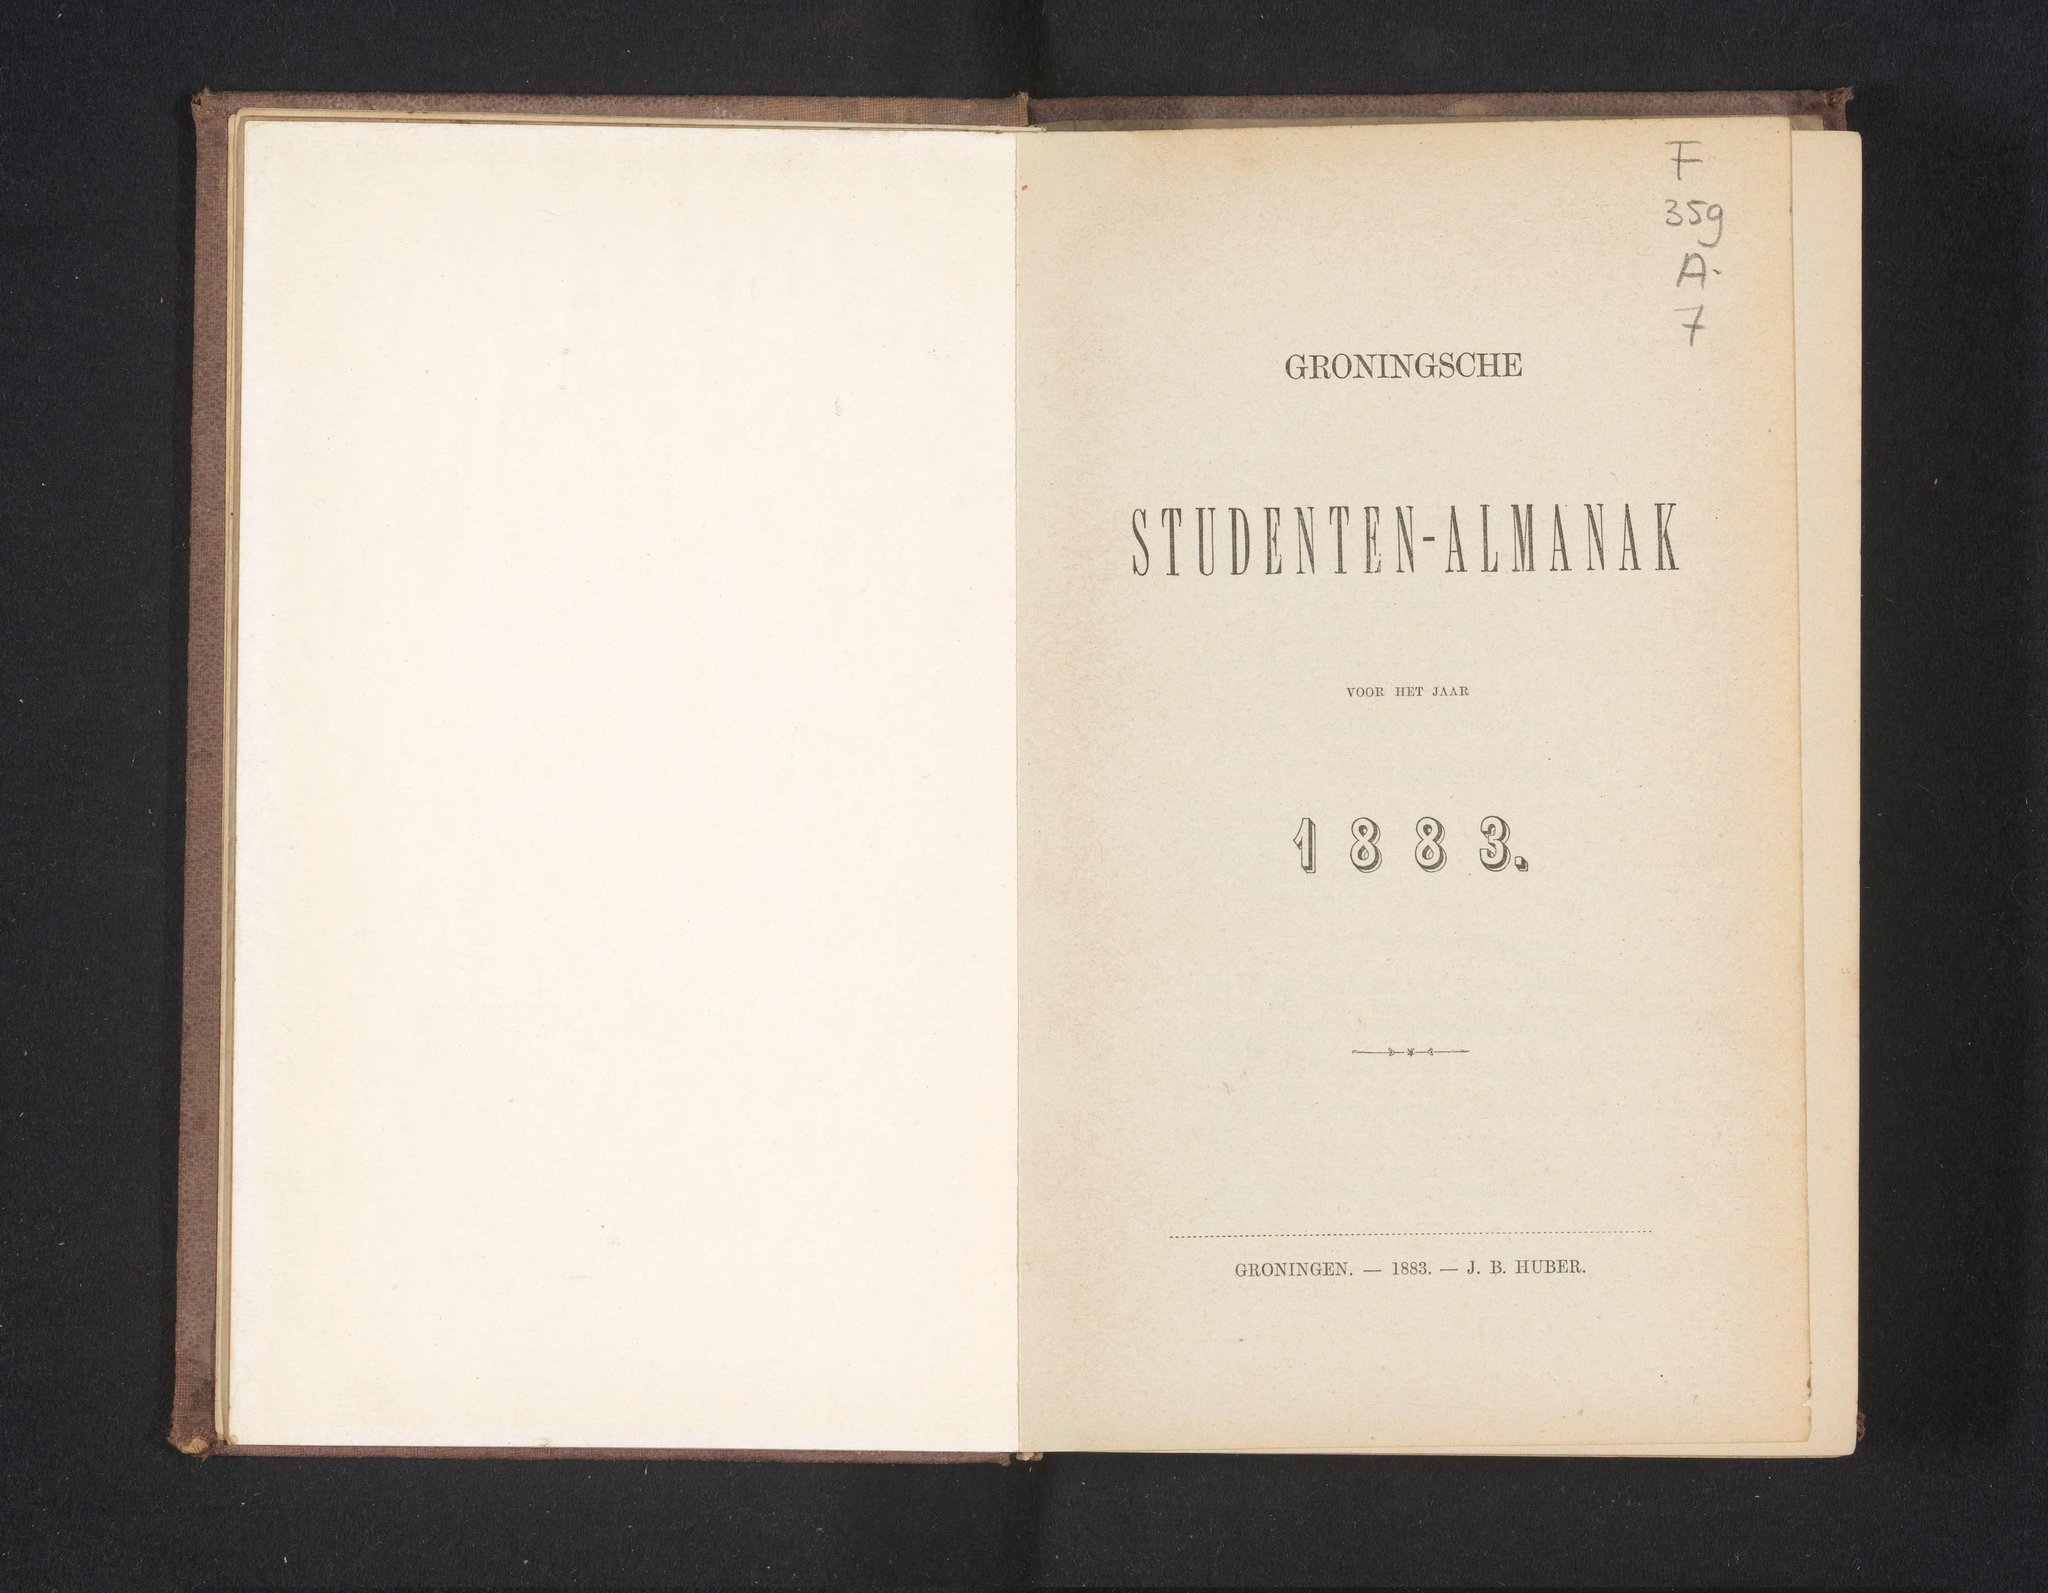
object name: book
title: Groninger studenten almanak voor het jaar 1883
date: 1883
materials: cardboard, linen, paper, photographic support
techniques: albumen print, lithograph, printing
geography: groningen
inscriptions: annotation: ‘JGI [...]inga Rz/ Balmahuizen’